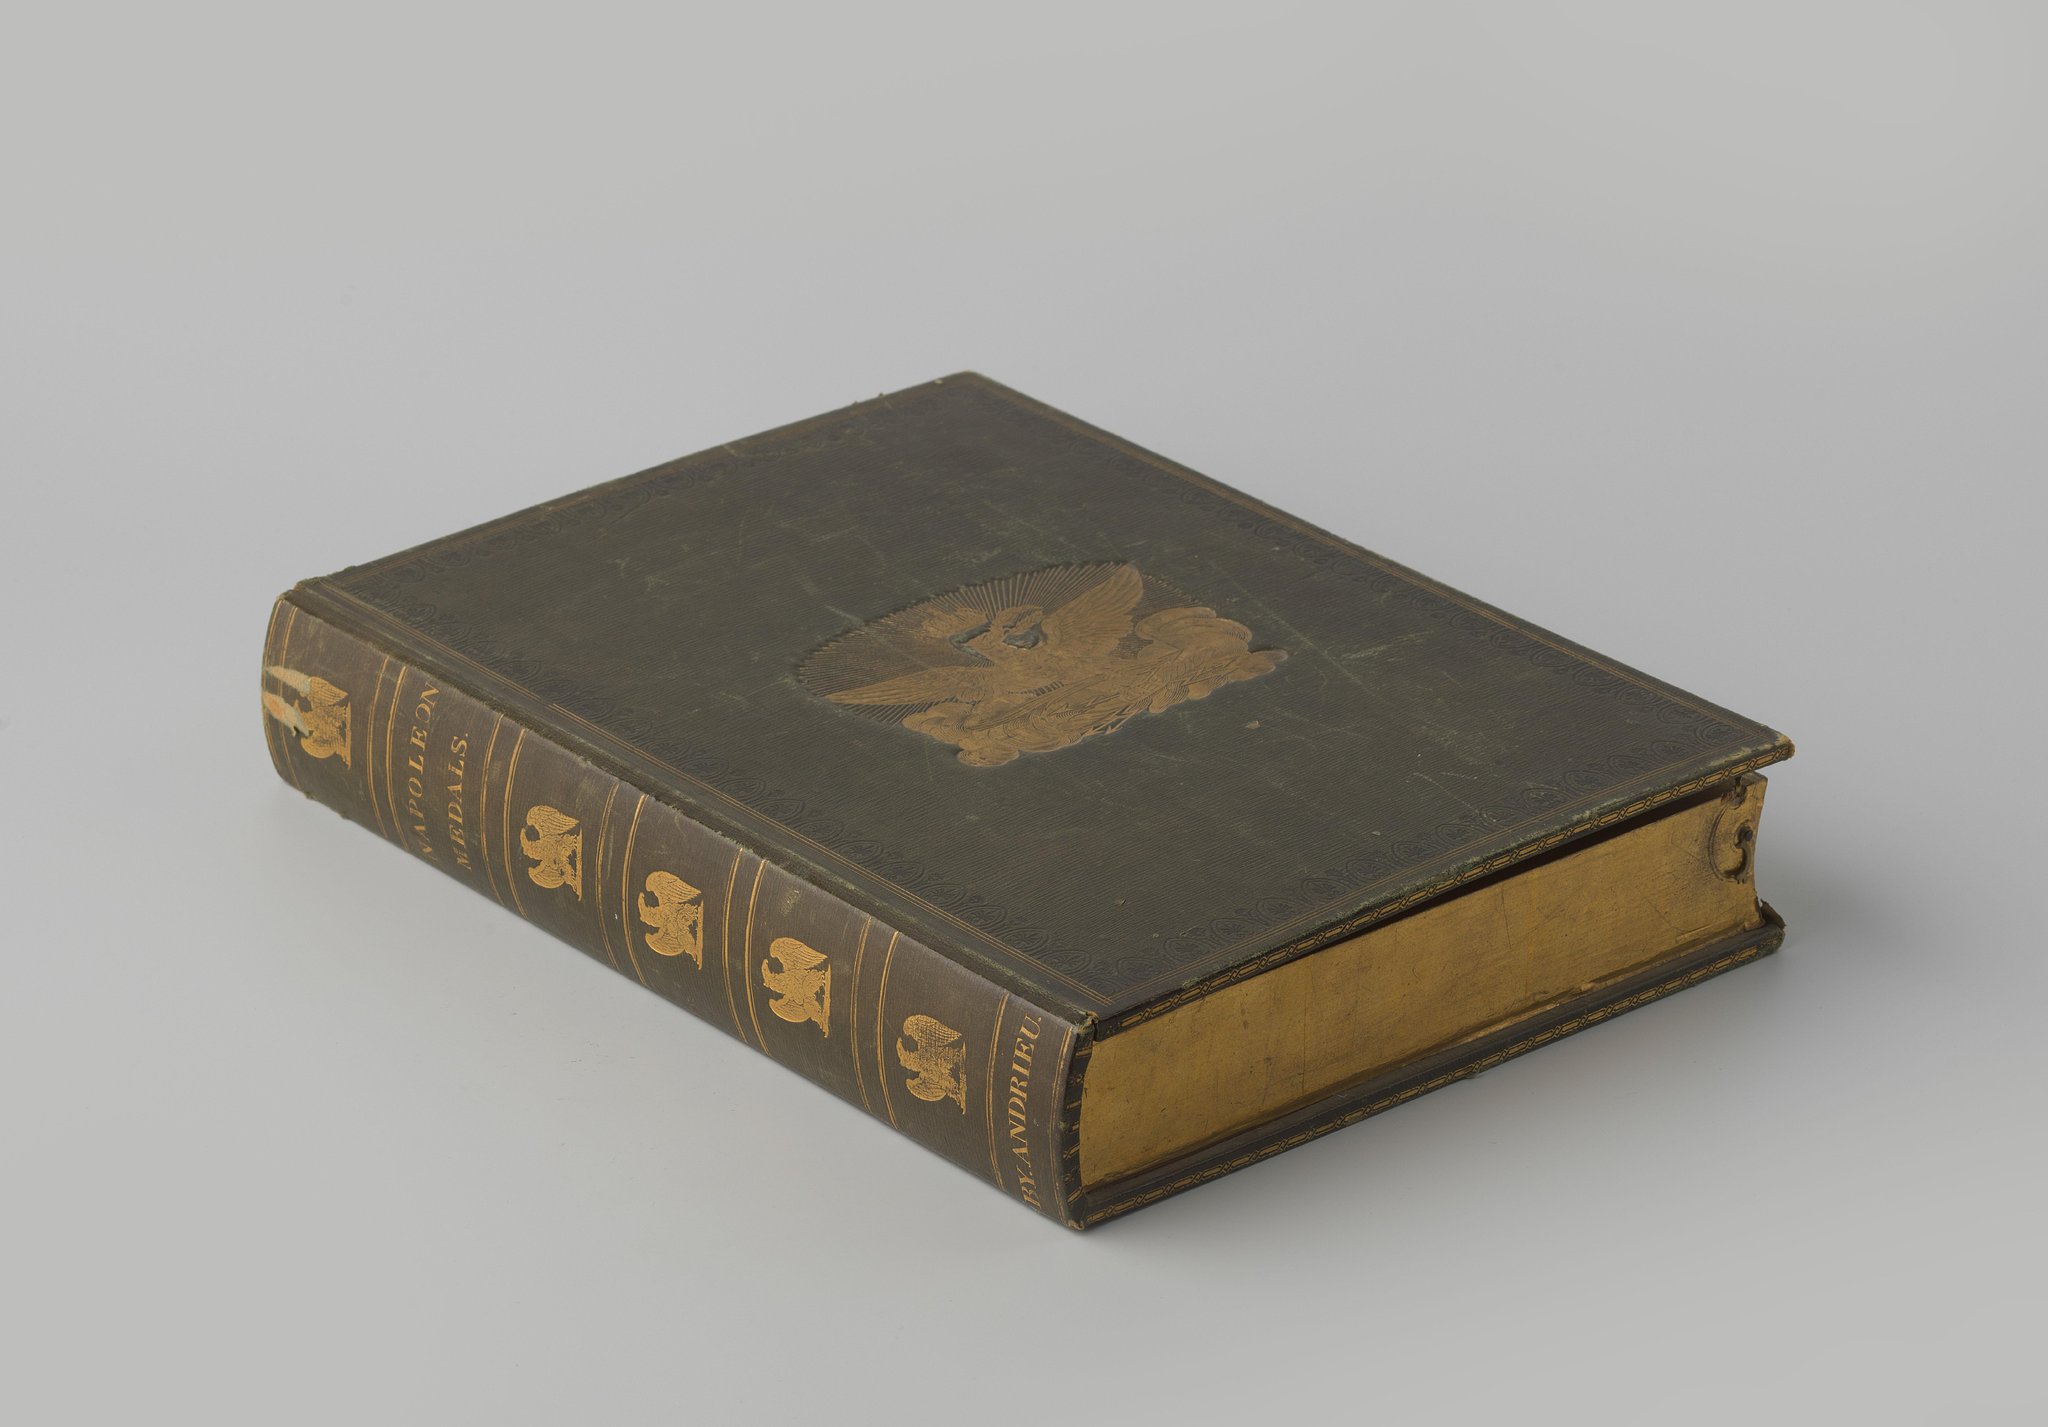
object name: cassette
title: Cassette in de vorm van een boek met daarin 10 penningen achter glas betrekking hebbend op leven en werken van Napoleon I Bonaparte, keizer der Fransen en zijn familie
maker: bertrand andrieu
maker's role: print maker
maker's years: 1761-1822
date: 1810-1815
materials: glass, gold leaf, leather, tin, wood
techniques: bronzing, striking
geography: paris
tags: joséphine de beauharnais, lodewijk xvi (koning van frankrijk), napoleon i (emperor of the french), vienna, marie louise van oostenrijk (keizerin der fransen), paris